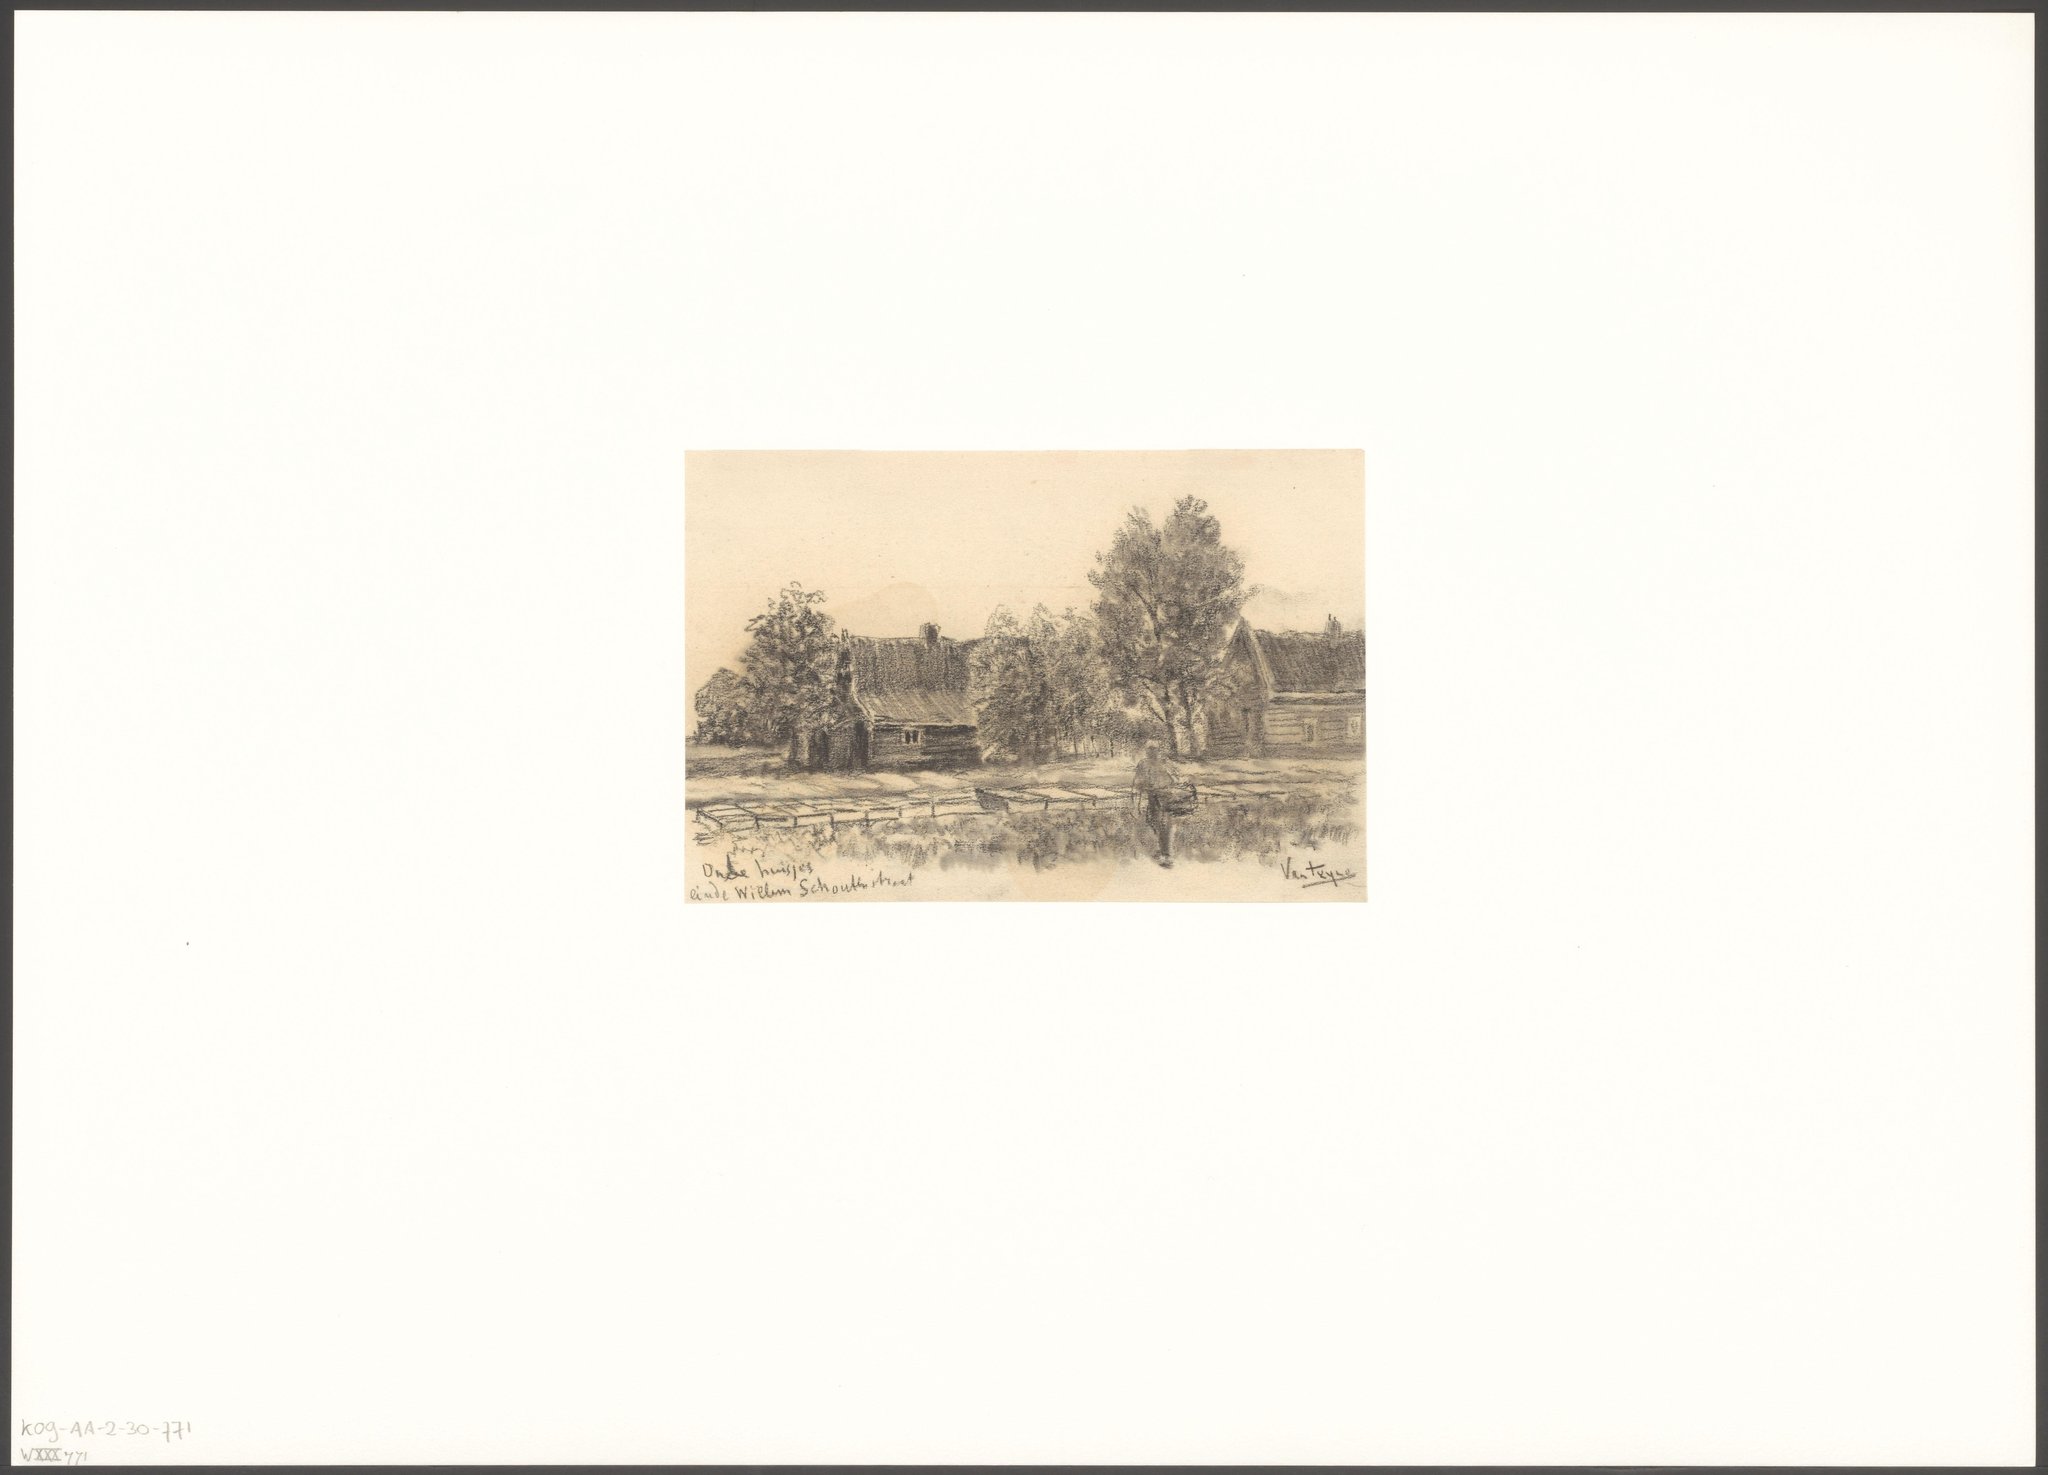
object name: drawing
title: Gezicht op groentetuinen achter de Van Spilbergenstraat, gezien vanuit de Willem Schoutenstraat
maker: anthonie van teijn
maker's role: draughtsman, painter, print maker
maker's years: 1863-1943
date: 1910-1927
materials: chalk, paper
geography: amsterdam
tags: horticulture, vegetable culture, market gardening, city-view in general; 'veduta', the usual house or row of houses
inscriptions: signature: ‘VanTeyne’, inscription: ‘Groenten tuinen achter (...) van Teijn / vEck’, collector's mark: Lugt 800a, inscription: ‘oude huisjes / einde Willem Schoutenstraat’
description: Tekening binnen de Atlas Van Eck ingedeeld op wijknummer 30.